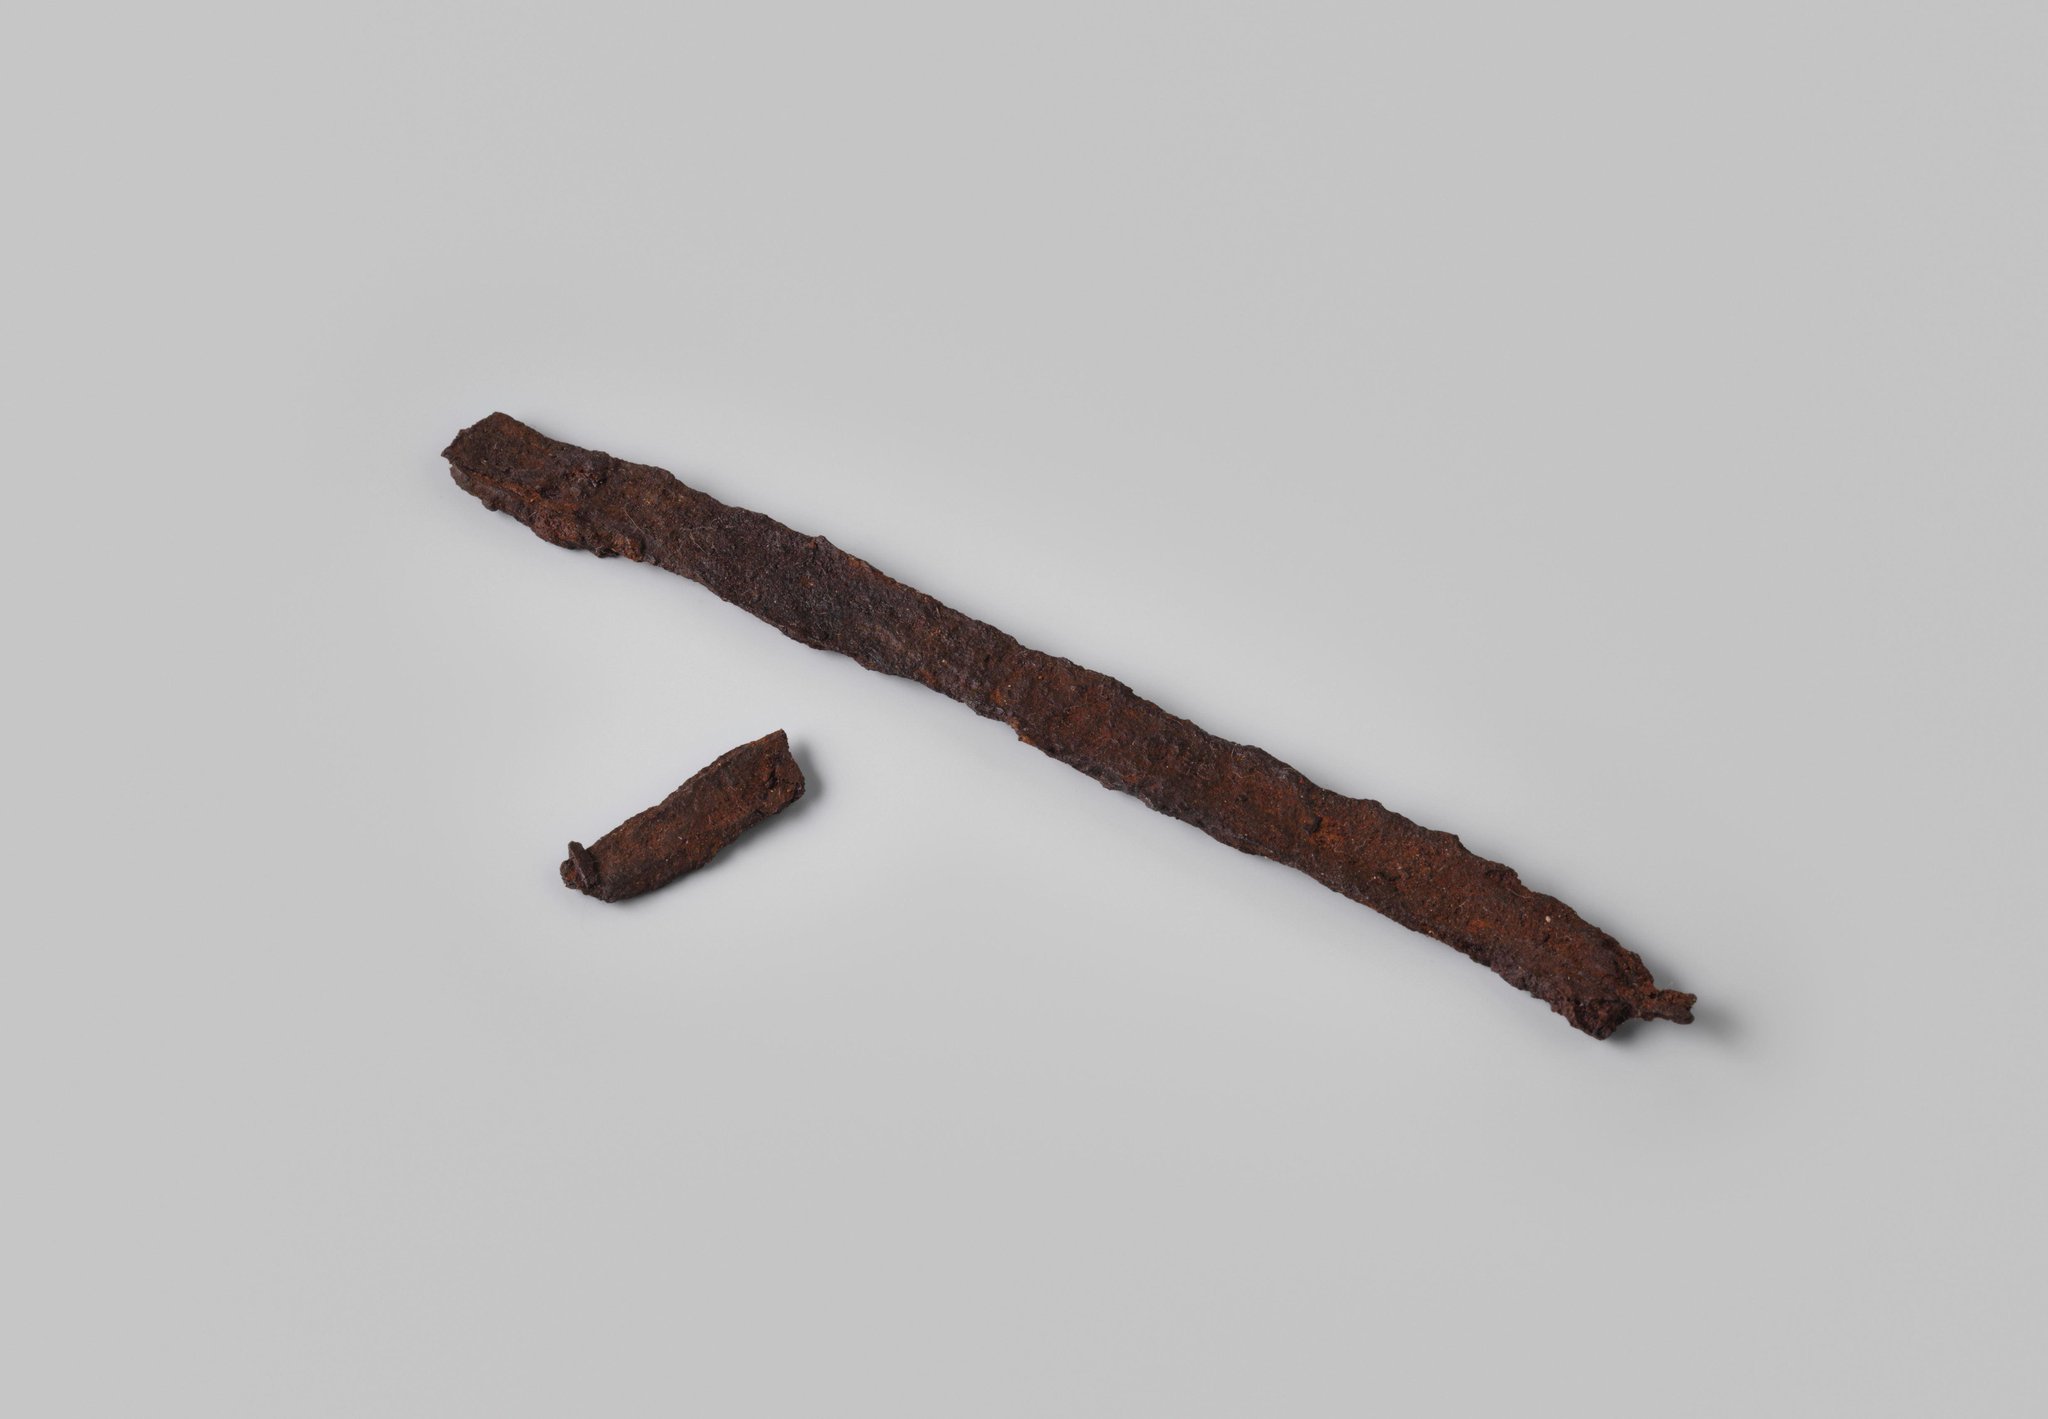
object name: strip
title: Gebroken fragment van ijzer uit het wrak van de Oost-Indiëvaarder Hollandia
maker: Anonymous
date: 1700-1743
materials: iron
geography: netherlands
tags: verenigde oostindische compagnie, hollandia (schip), annet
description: Varied parts or fragments, strip and strip-shaped fragments; fragm, heavily eroded, broken, flat, straight, bevelled rims.